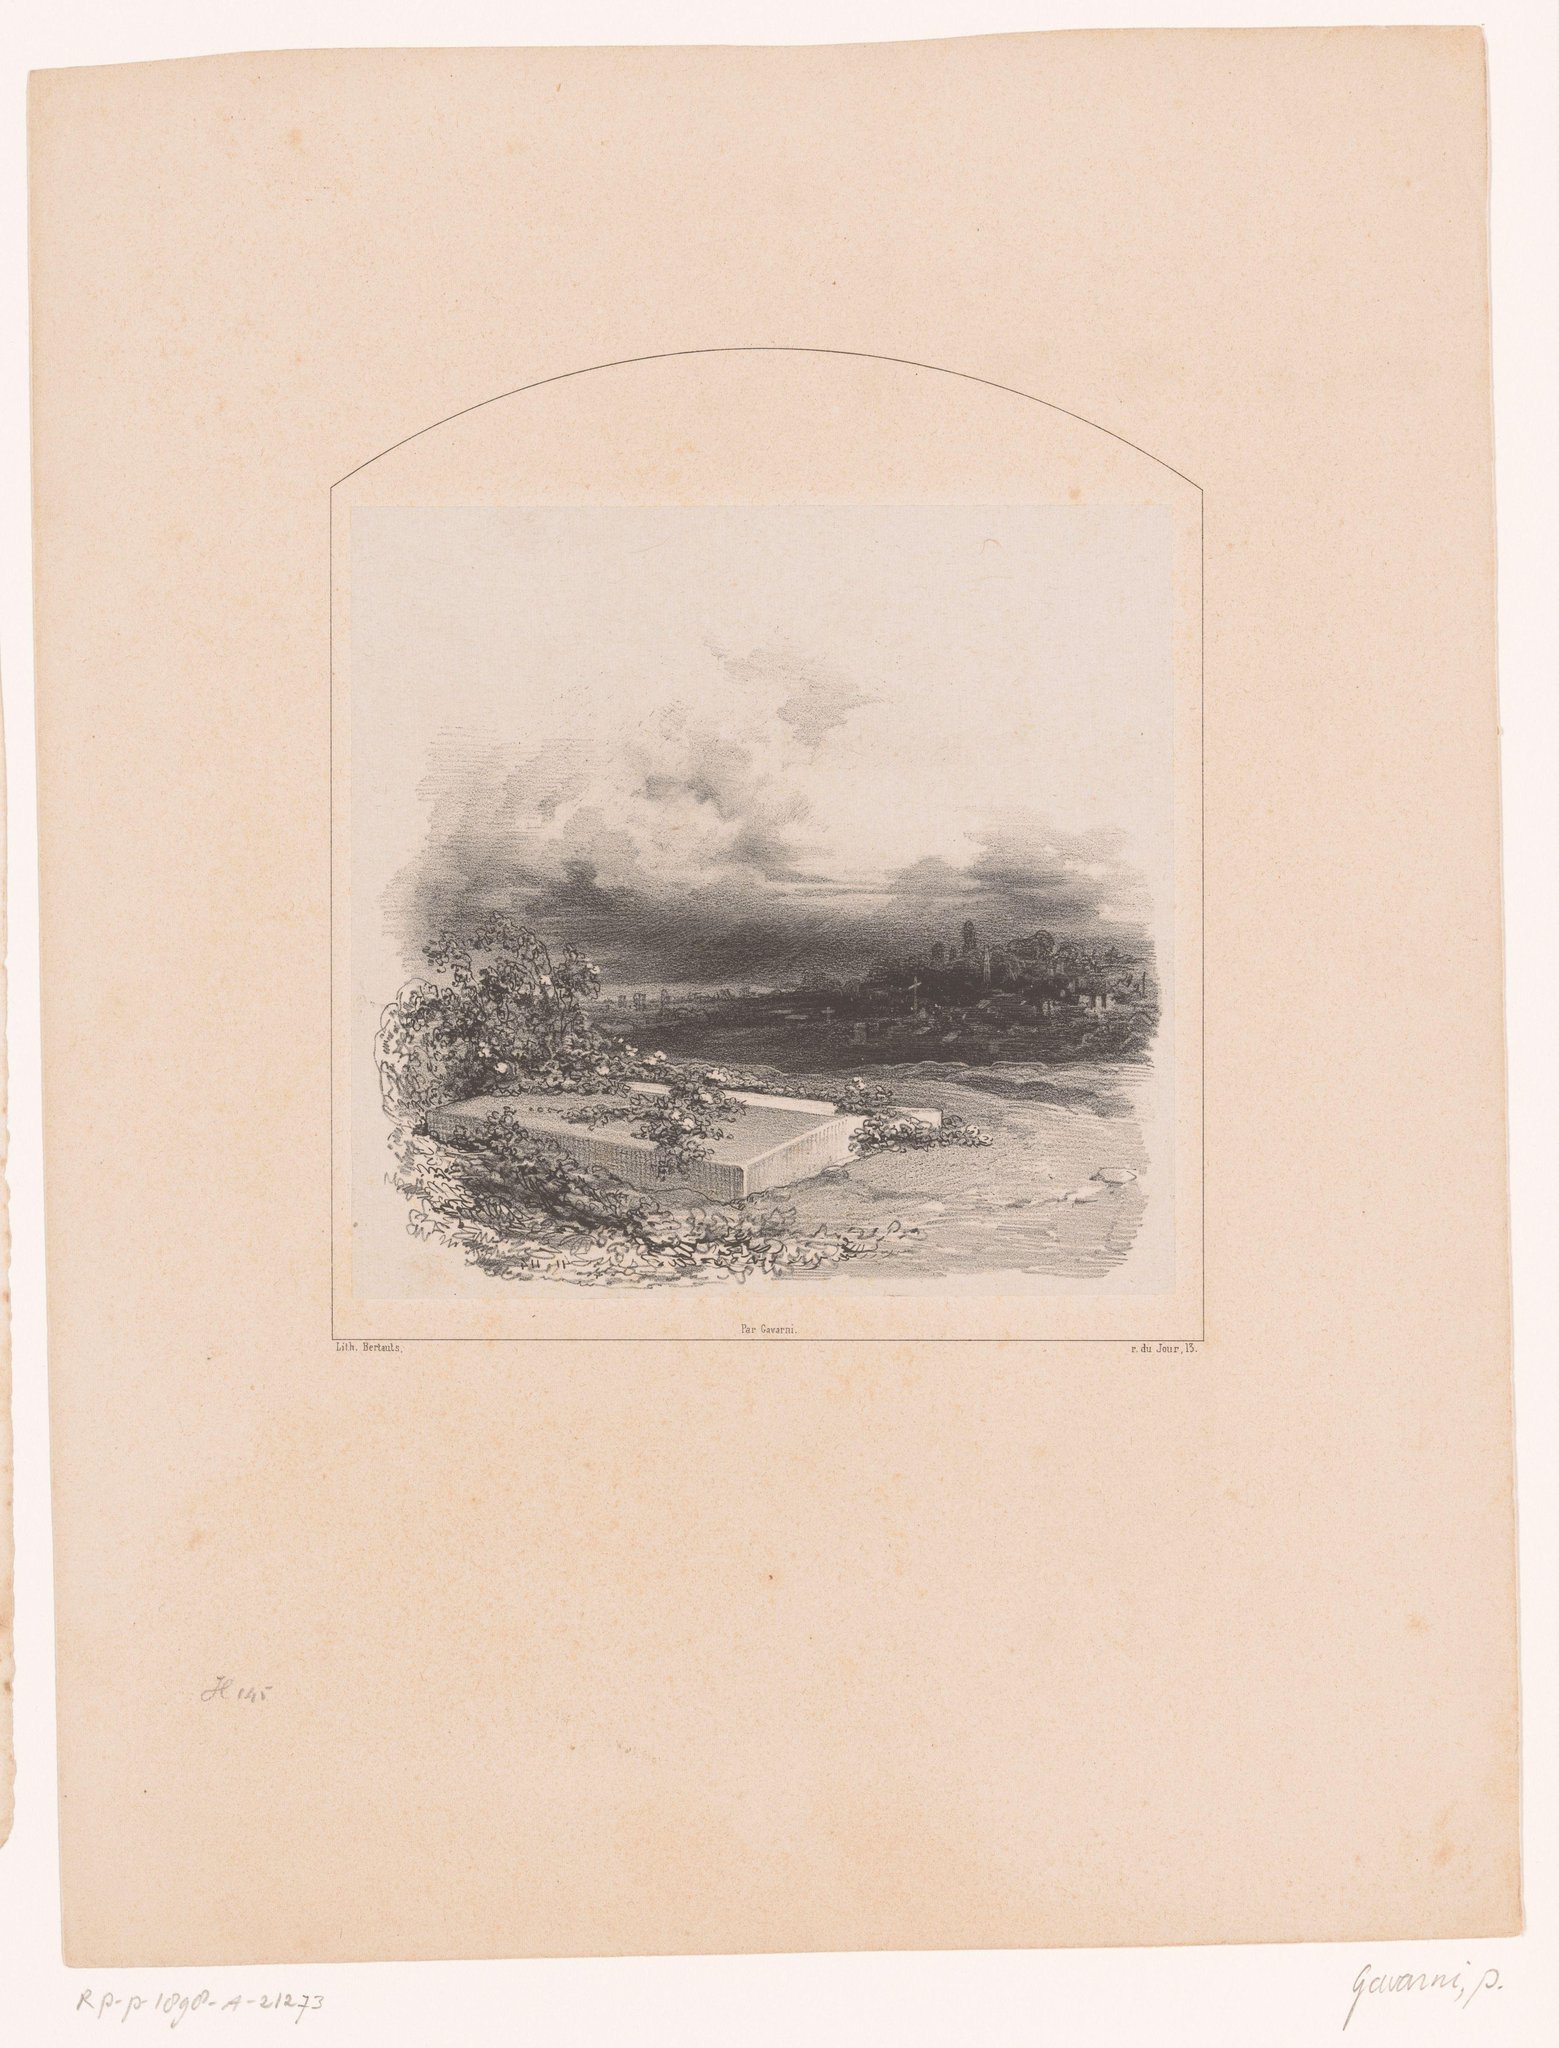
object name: print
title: Landschap met grafsteen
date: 1841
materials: paper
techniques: lithograph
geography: paris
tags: flat, horizontal gravestone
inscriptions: collector's mark: Lugt 964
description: Prent gebruikt als illustratie voor de elegie Elle est morte, in het album met bladmuziek Les Lys et les roses, Parijs: Bertauts, 1841. Prent ook gebruikt voor: Bulletin de l'Ami des arts, dl. 2, 1844.